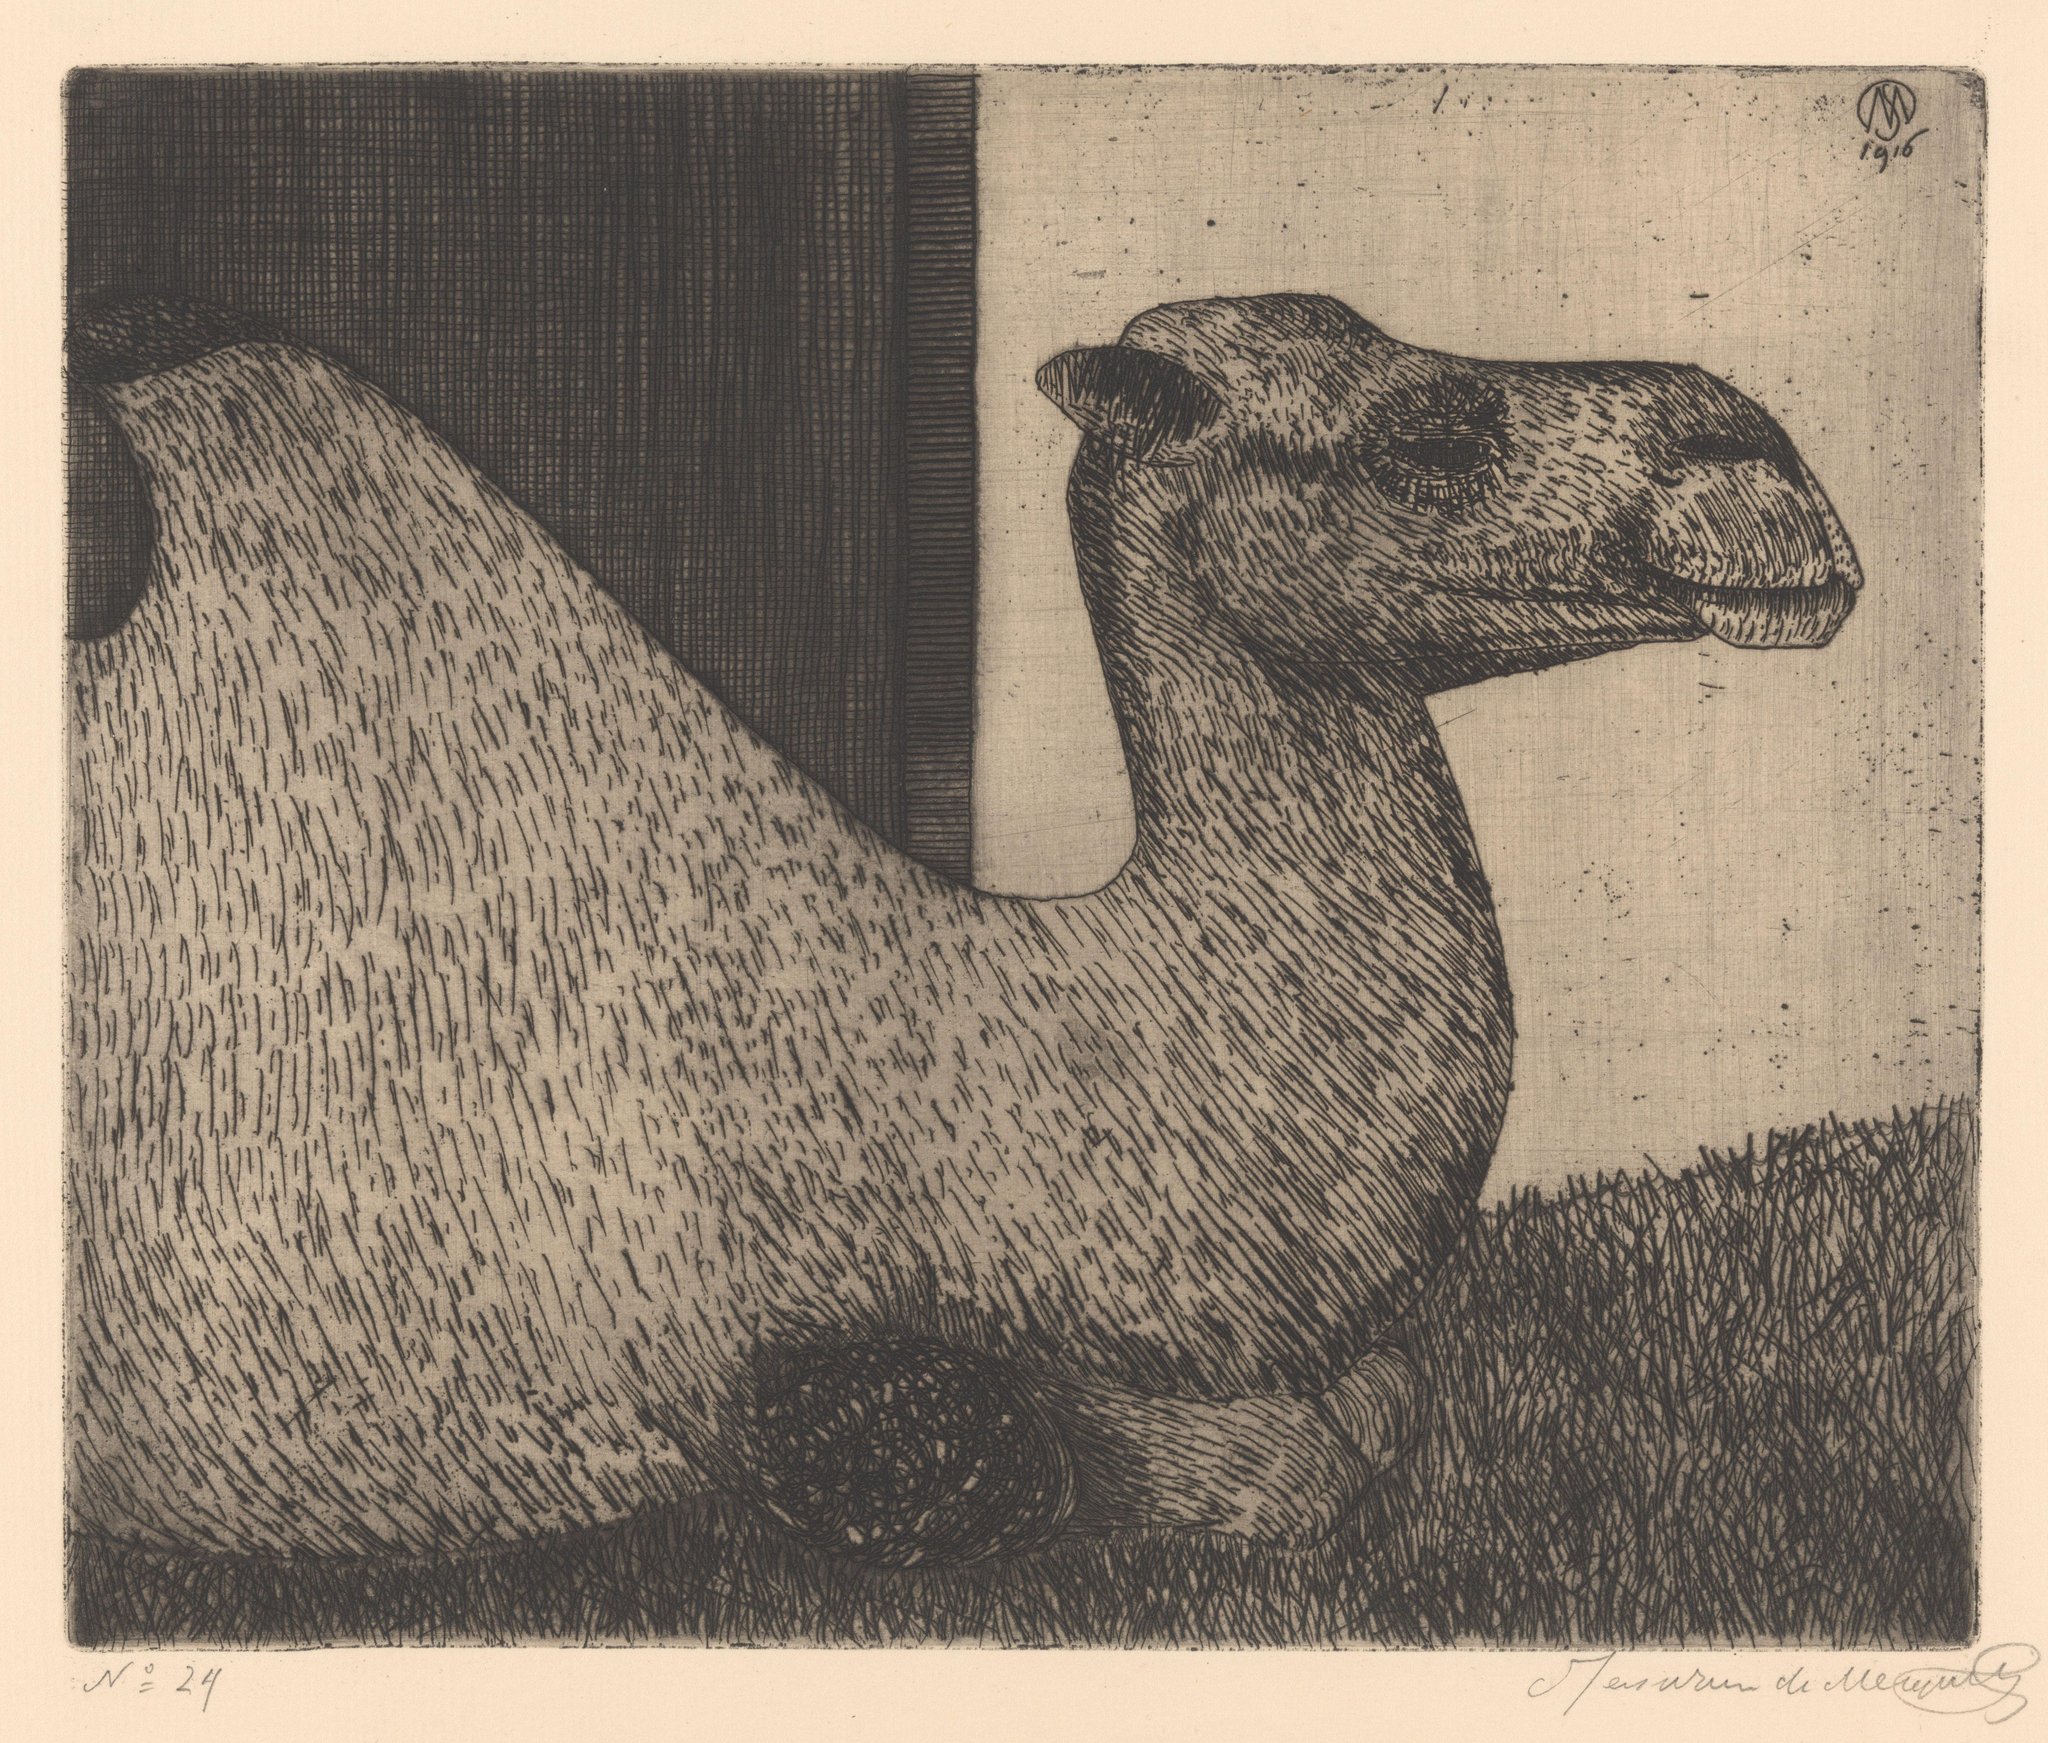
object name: print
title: Dromedaris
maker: samuel jessurun de mesquita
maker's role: draughtsman, print maker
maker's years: 1868-1944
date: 1916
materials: paper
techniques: aquatint, etching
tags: hoofed animals: camel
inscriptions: collector's mark: Lugt 2228, number: ‘No 24’